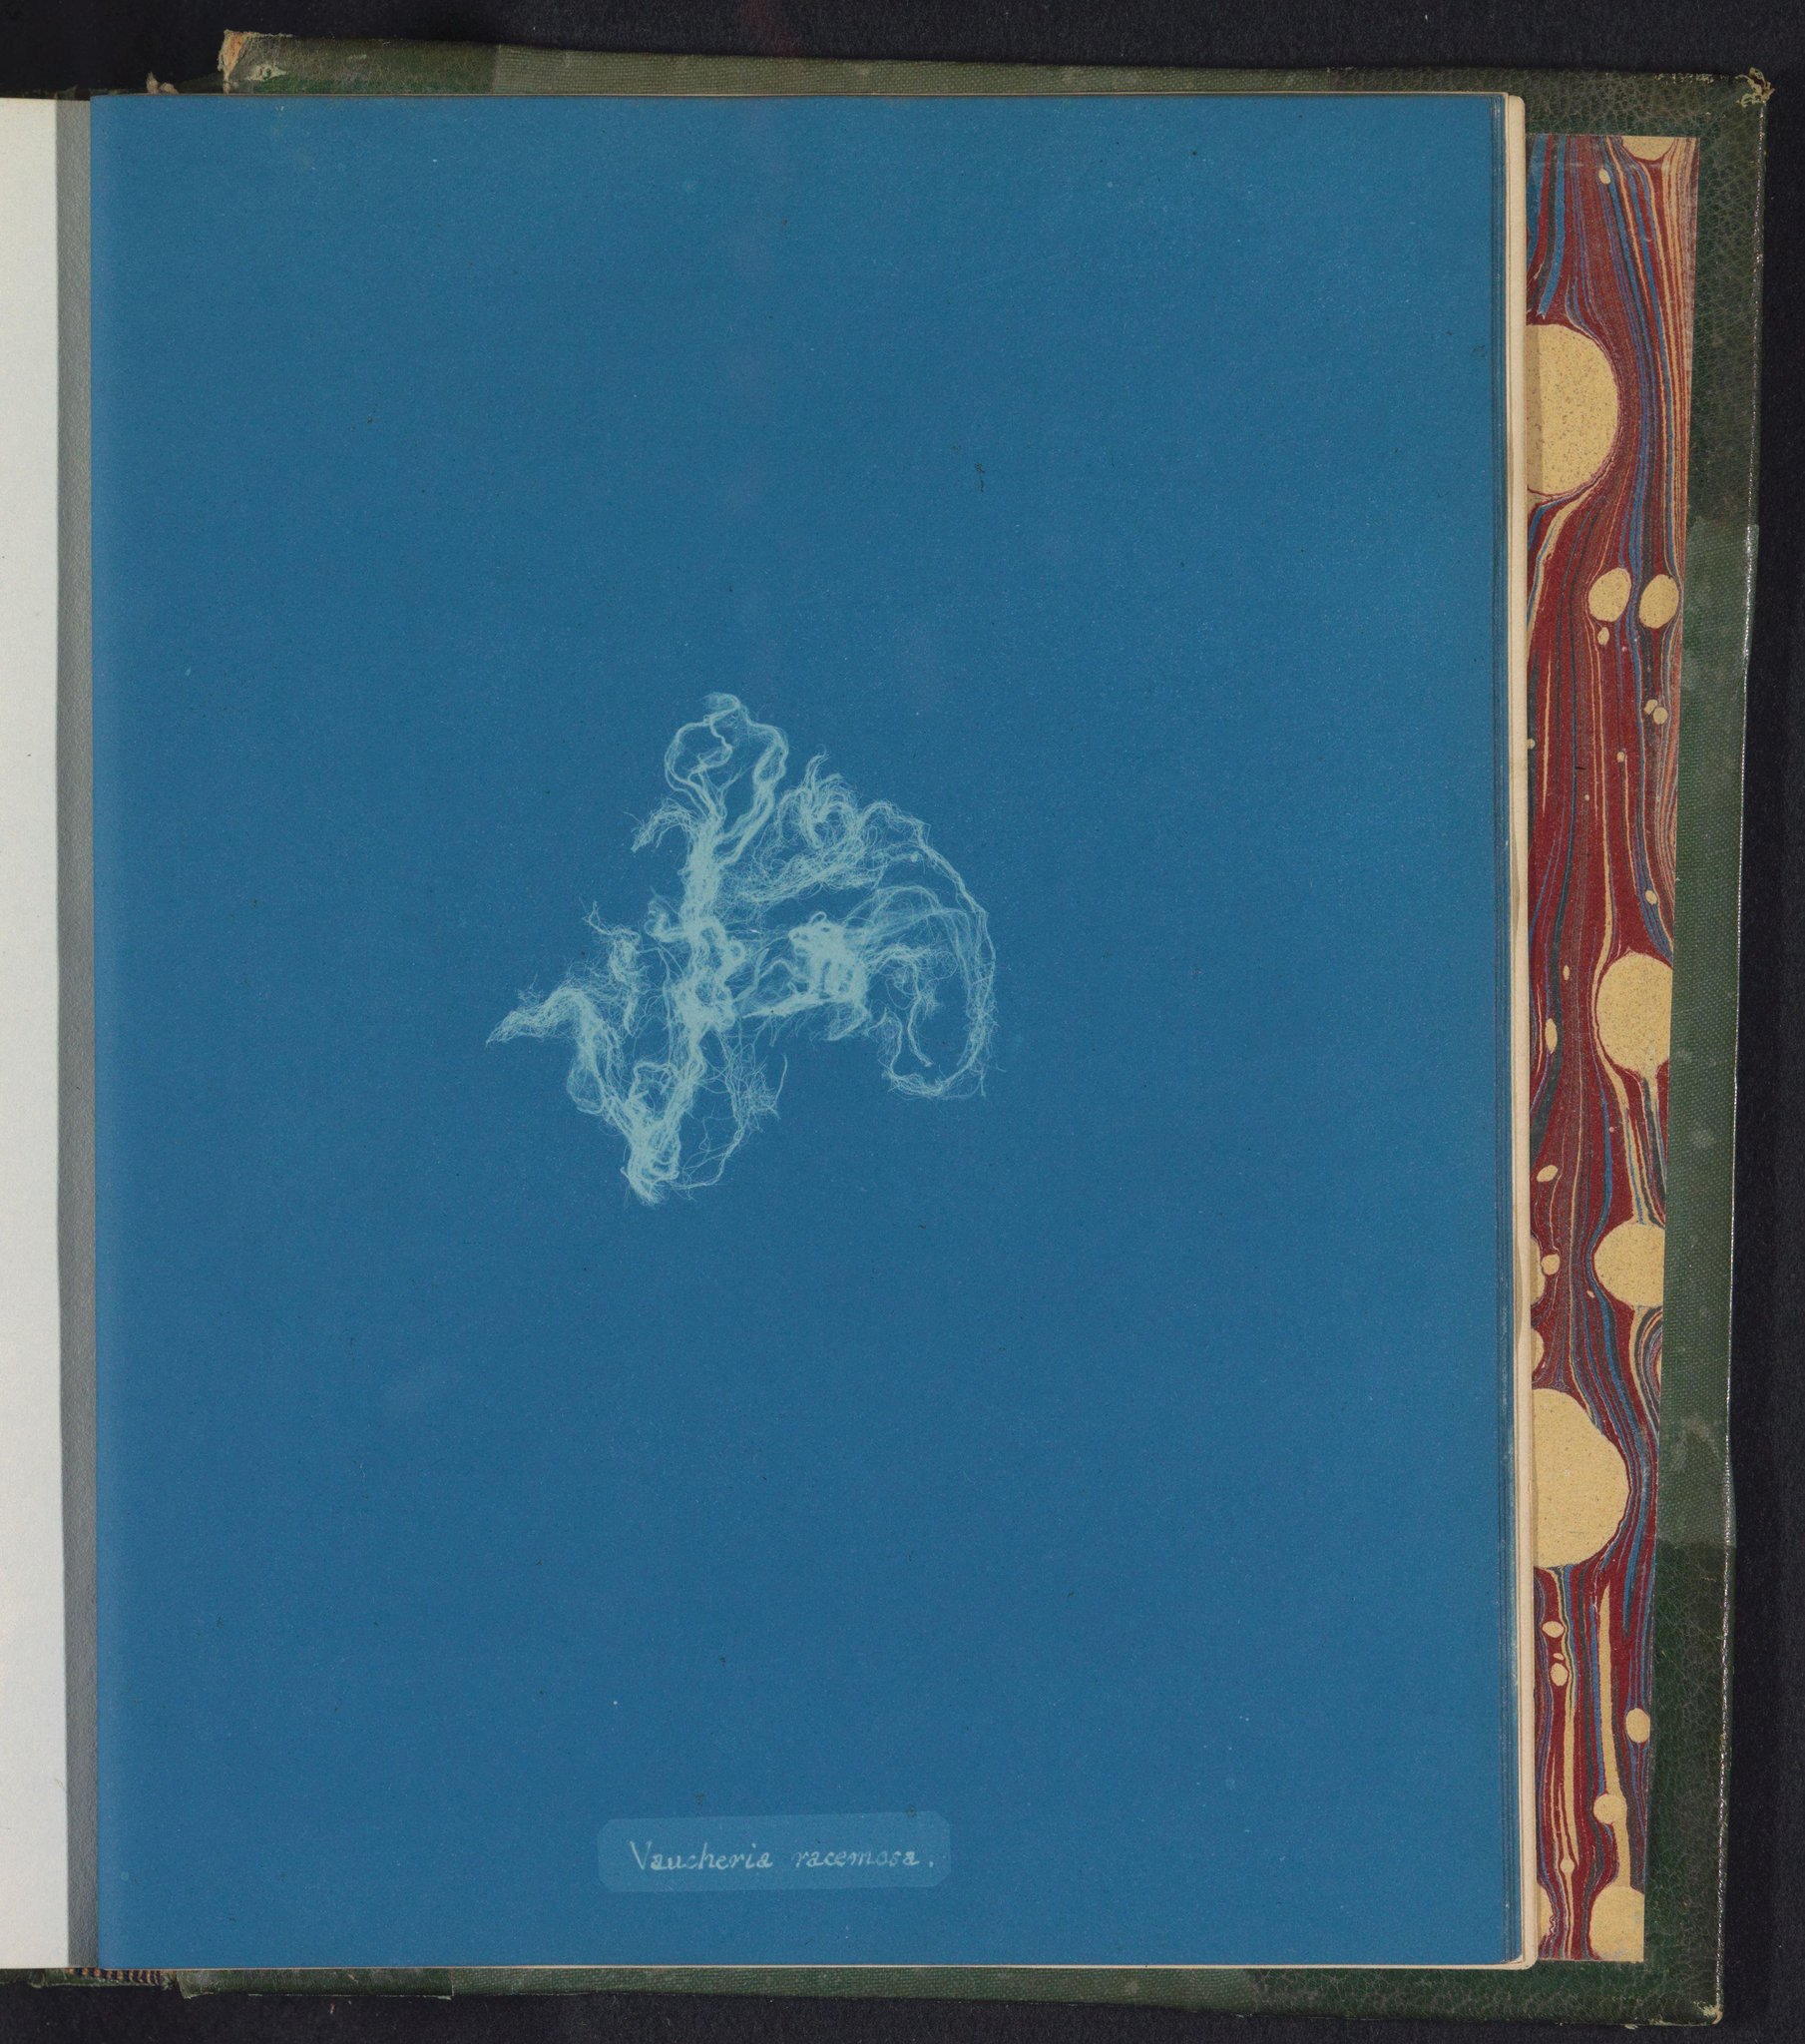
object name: photograph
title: Vaucheria racemosa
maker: anna atkins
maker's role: fotograaf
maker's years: 1799-1871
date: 1843-1853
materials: photographic support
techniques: cyanotype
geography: united kingdom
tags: algae, seaweed